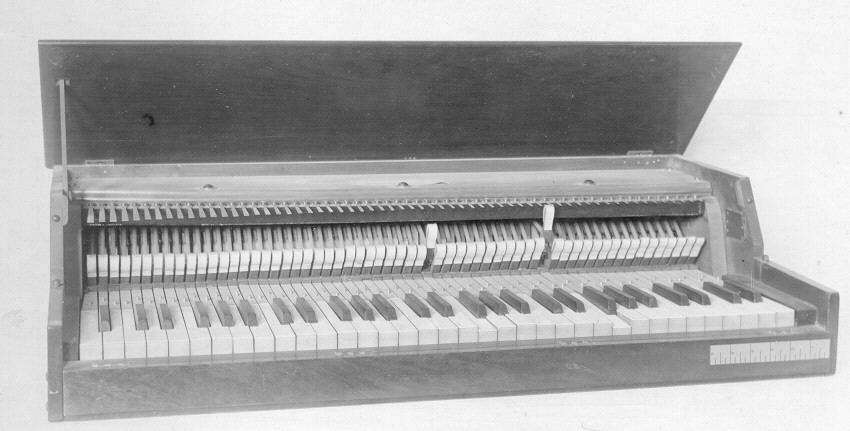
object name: harmonica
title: Piano Harmonica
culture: british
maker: j. b. cramer & co.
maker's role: maker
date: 1870-1896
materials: wood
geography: united kingdom